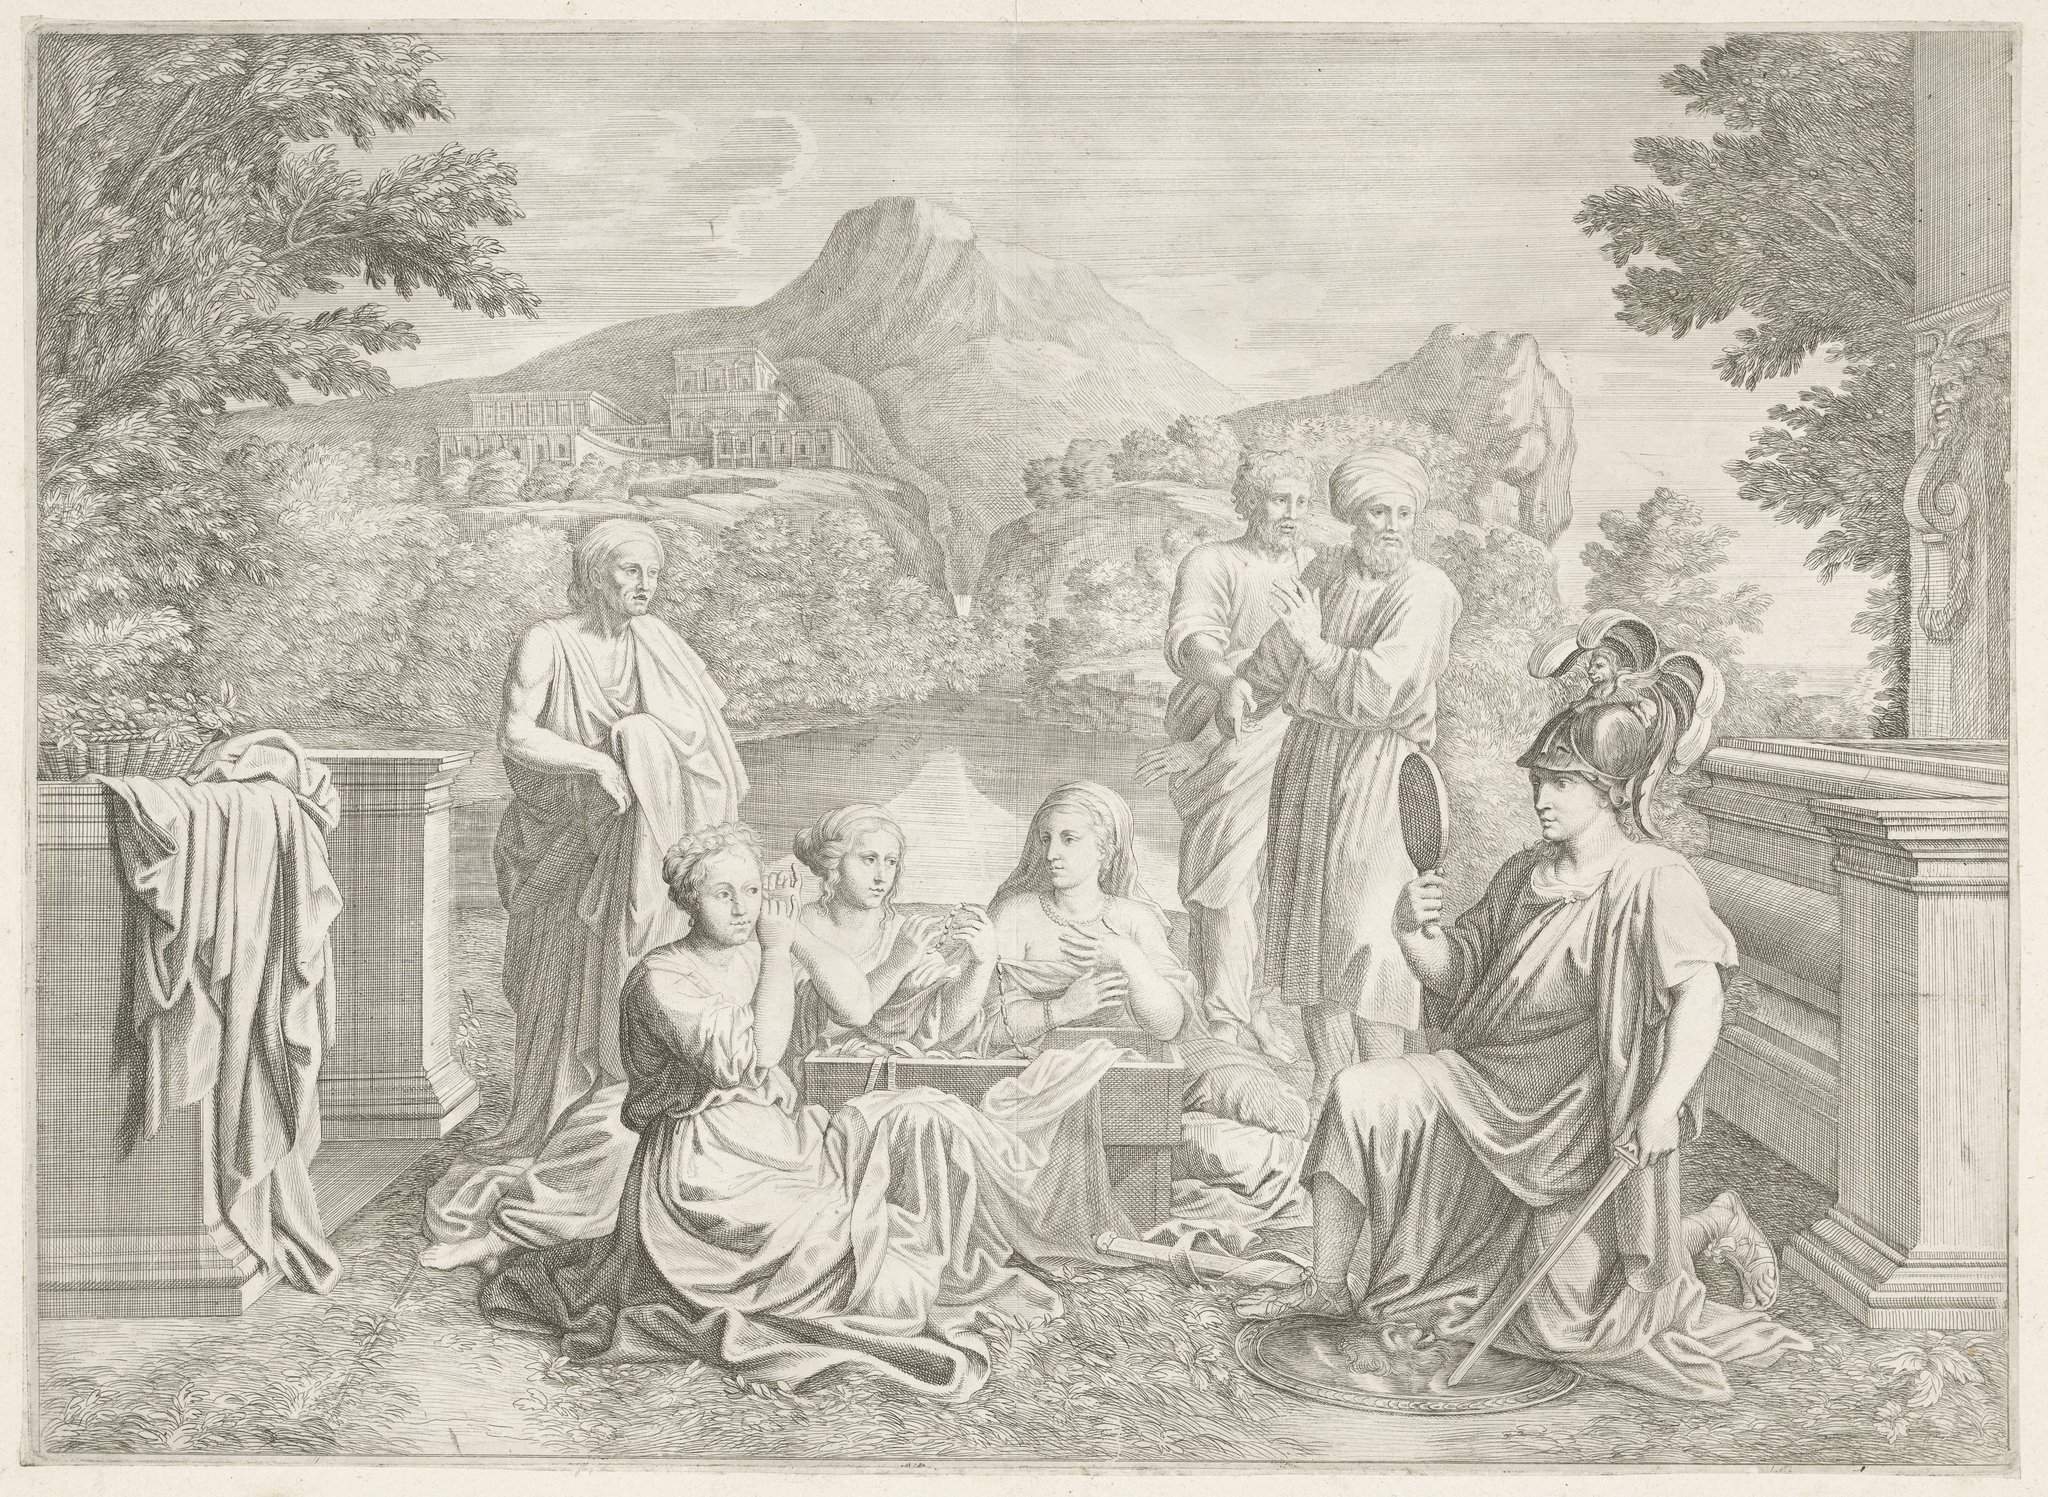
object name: print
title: Achilles door Odysseus herkend temidden van de dochters van Lycomedes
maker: pietro del po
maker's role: print maker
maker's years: 1610-1692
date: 1620-1692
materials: paper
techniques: etching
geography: italy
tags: achilles discovered among the daughters of lycomedes, i.e. achilles on scyros: when presents are brought achilles snatches up the weapons and thus betrays his identity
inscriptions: collector's mark: Lugt 240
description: De dochters van koning Lycomedus zitten rond een kist met kostbaarheden. Samen met twee mannen kijken ze verbaasd op naar de als vrouw verklede Achilles die zijn ware identiteit verraadt door een helm op te zetten.